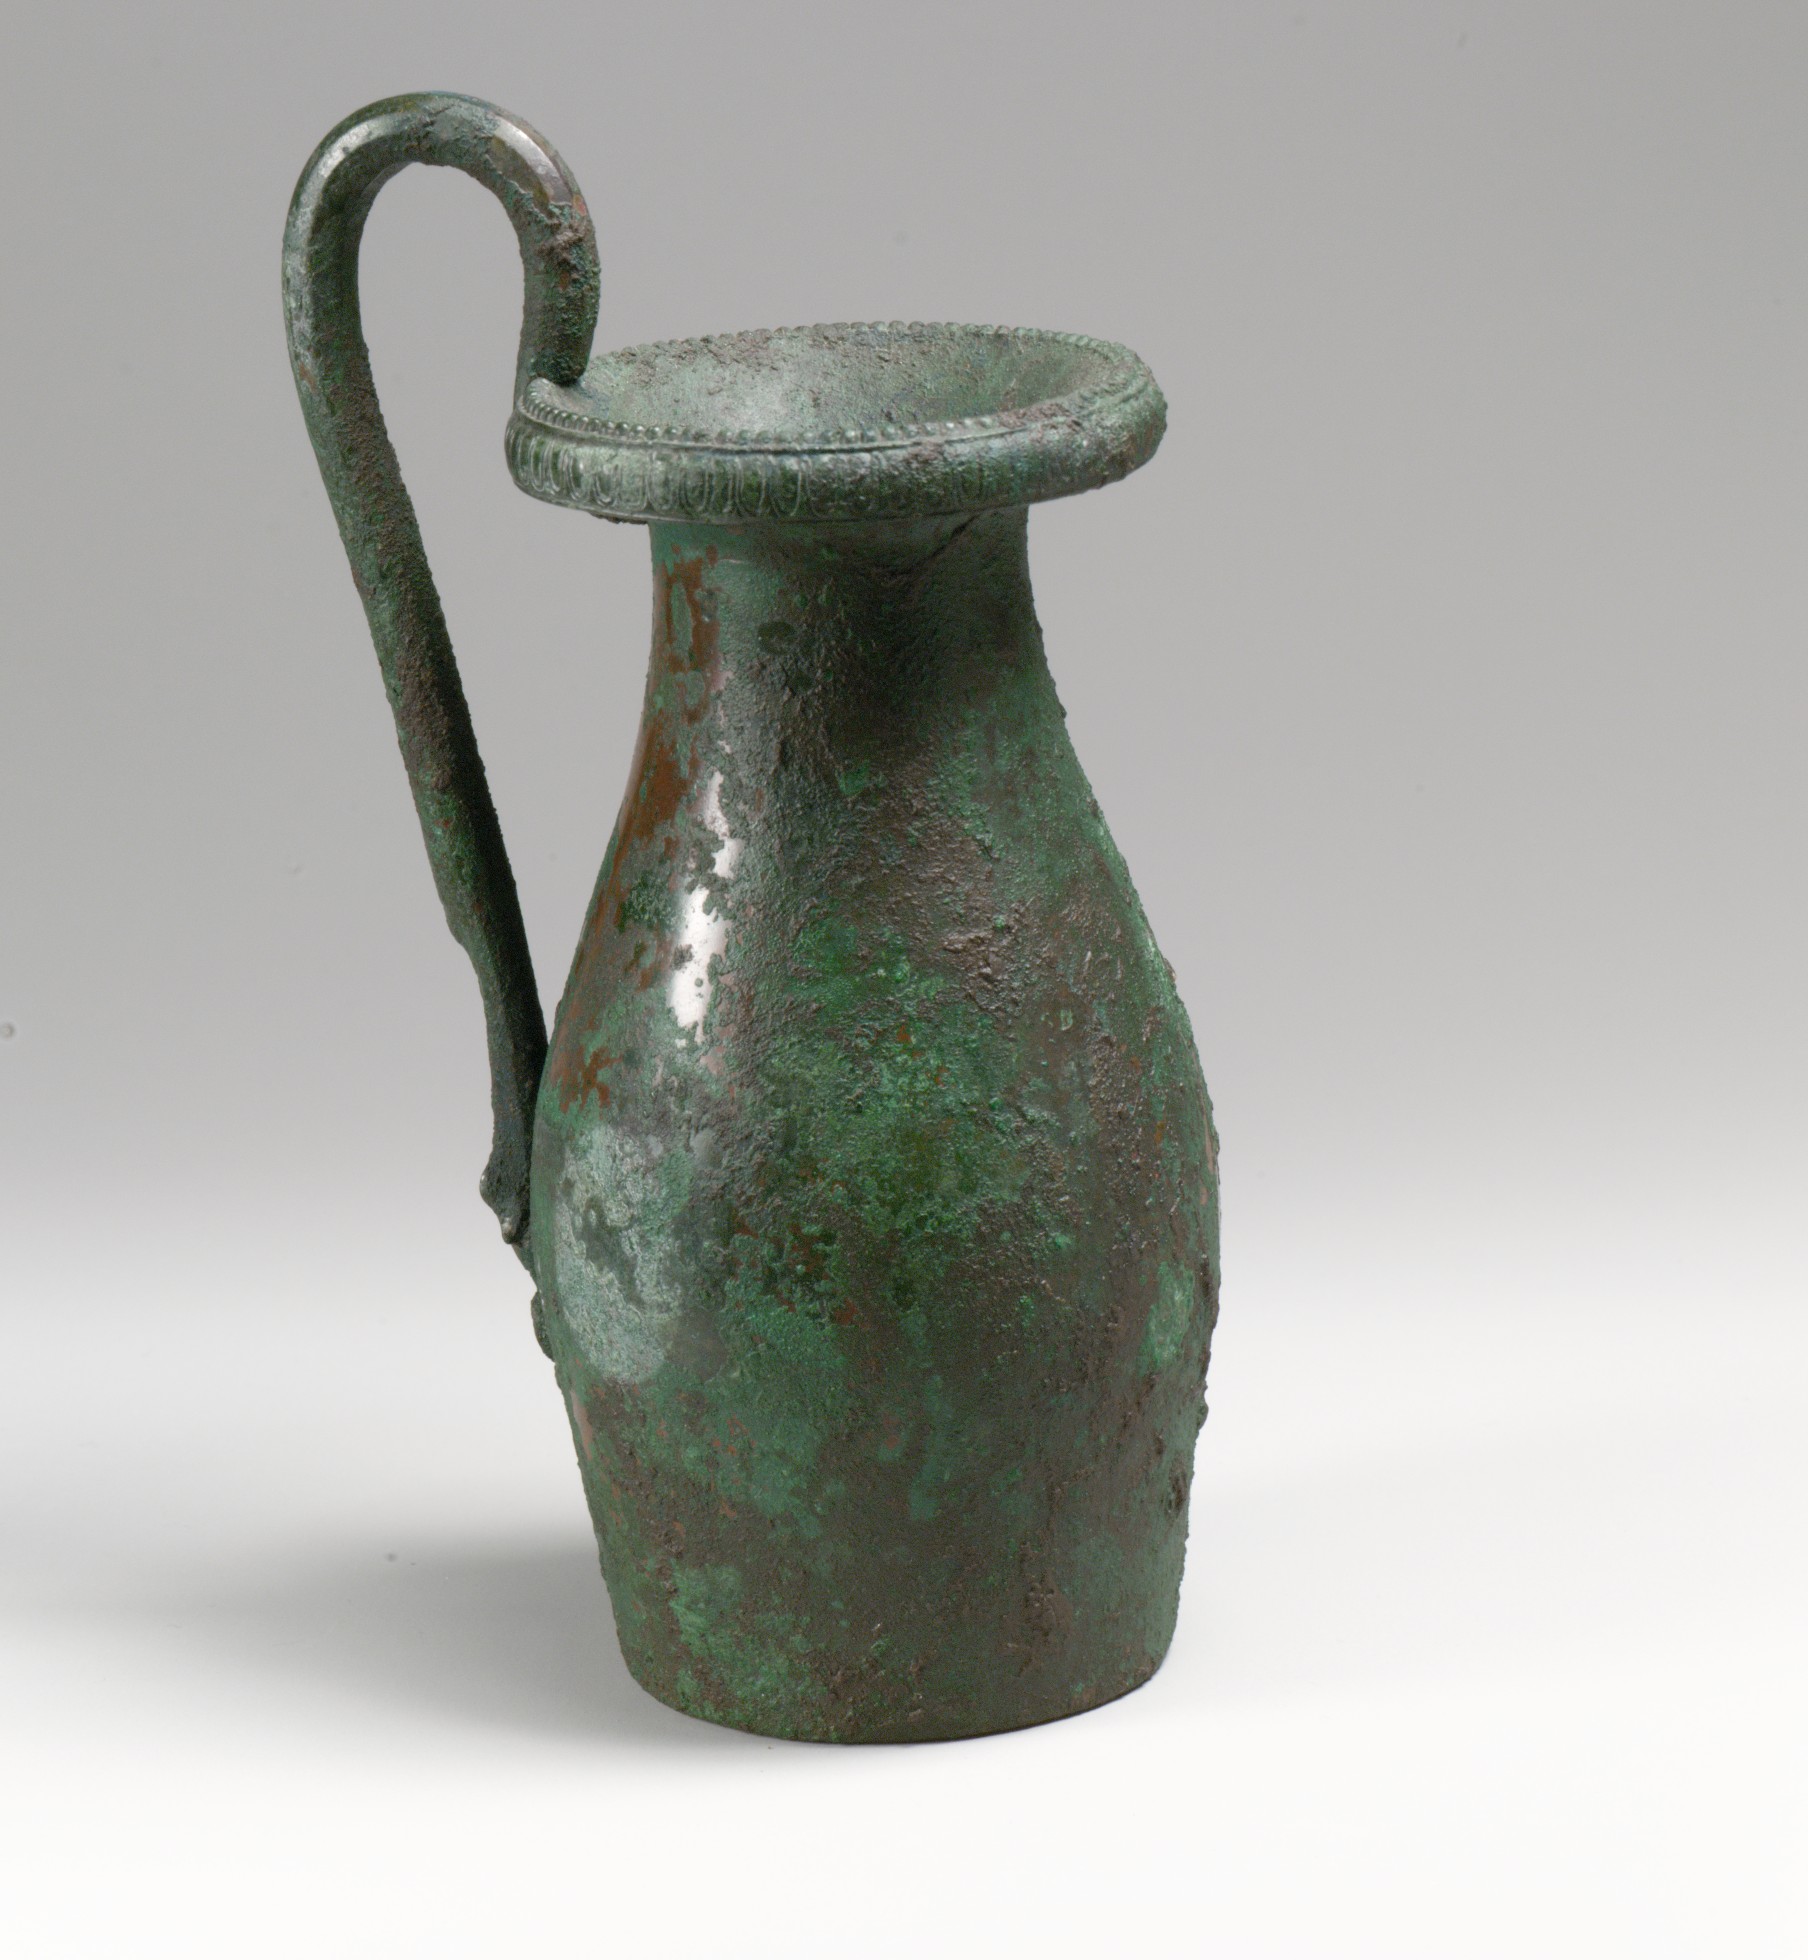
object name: jug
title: Bronze jug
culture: etruscan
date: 500-468 BCE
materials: bronze